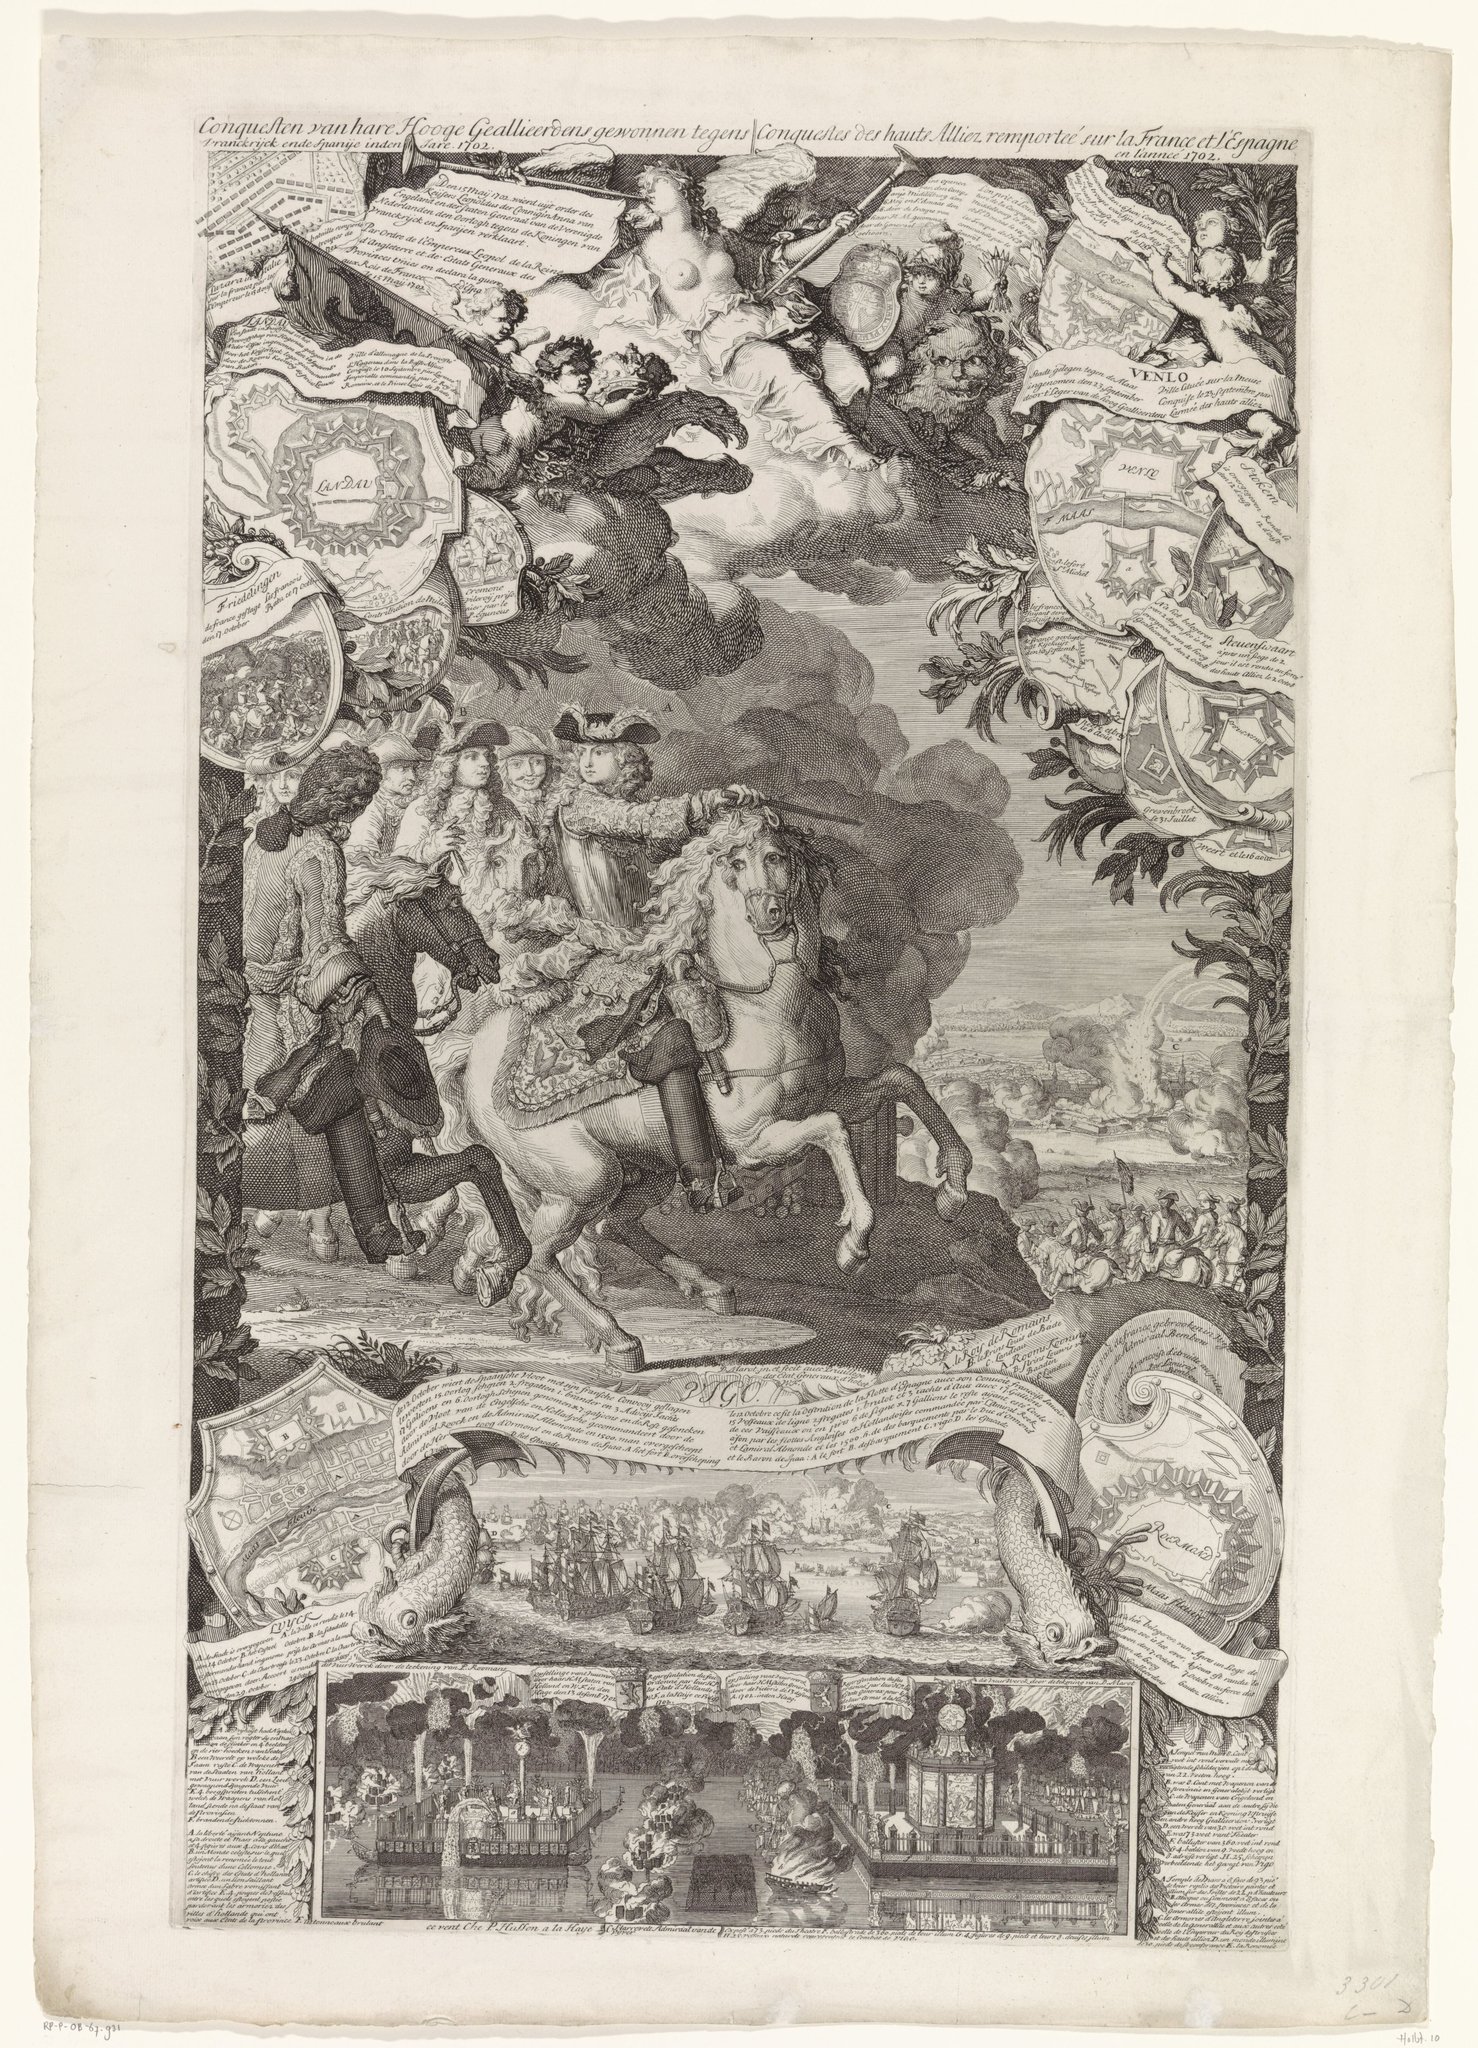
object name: print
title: Conquesten van hare Hooge Geallieerdens gewonnen tegens Vranckrijck ende Spanije inden Jare 1702 / Conquestes des hauts Alliez remportée sur la France et L'Espagne en l'anneé 1702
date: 1702-1704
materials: paper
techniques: engraving, etching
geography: the hague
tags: vienna, jozef i (duits keizer), paris, equestrian state-portrait, bonfire, fire-works - aa - festivities on the water, battle (+ land forces), liège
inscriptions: collector's mark: Lugt 2228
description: Overwinning van de geallieerden op de Fransen en Spanjaarden in het jaar 1702. Centraal de Roomse koning Jozef I en de markgraaf van Baden te paard, begeleid door hun bevelhebbers. Zij worden omgeven door verschillende oorlogstaferelen en belegerde plaatsen, onder andere Landau, Vigos, Venlo, Luik en Roermond. In de wolken de Faam, engelen, de Nederlandse Leeuw en de Duitse adelaar. Onderaan het vuurwerk afgestoken op last van de Staten-Generaal en de Staten van Holland en West-Friesland op de Hofvijver te Den Haag op 13 decmber 1702. Alle opschriften in het Nederlands en Frans.